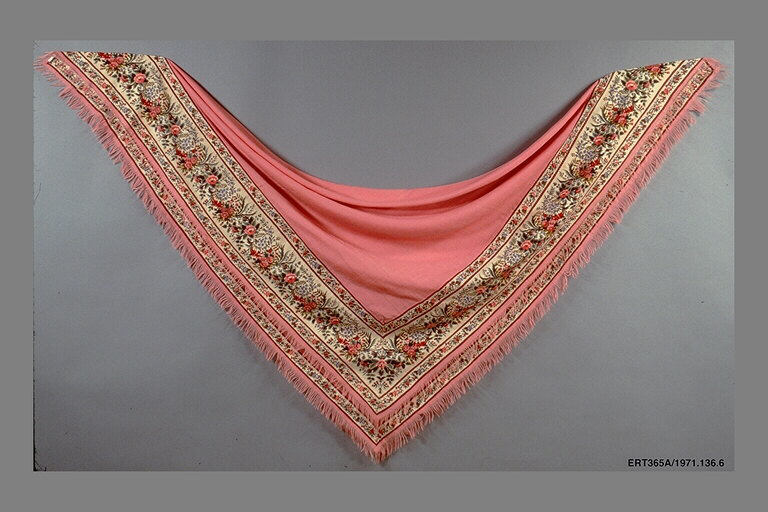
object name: shawl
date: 1850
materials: wool